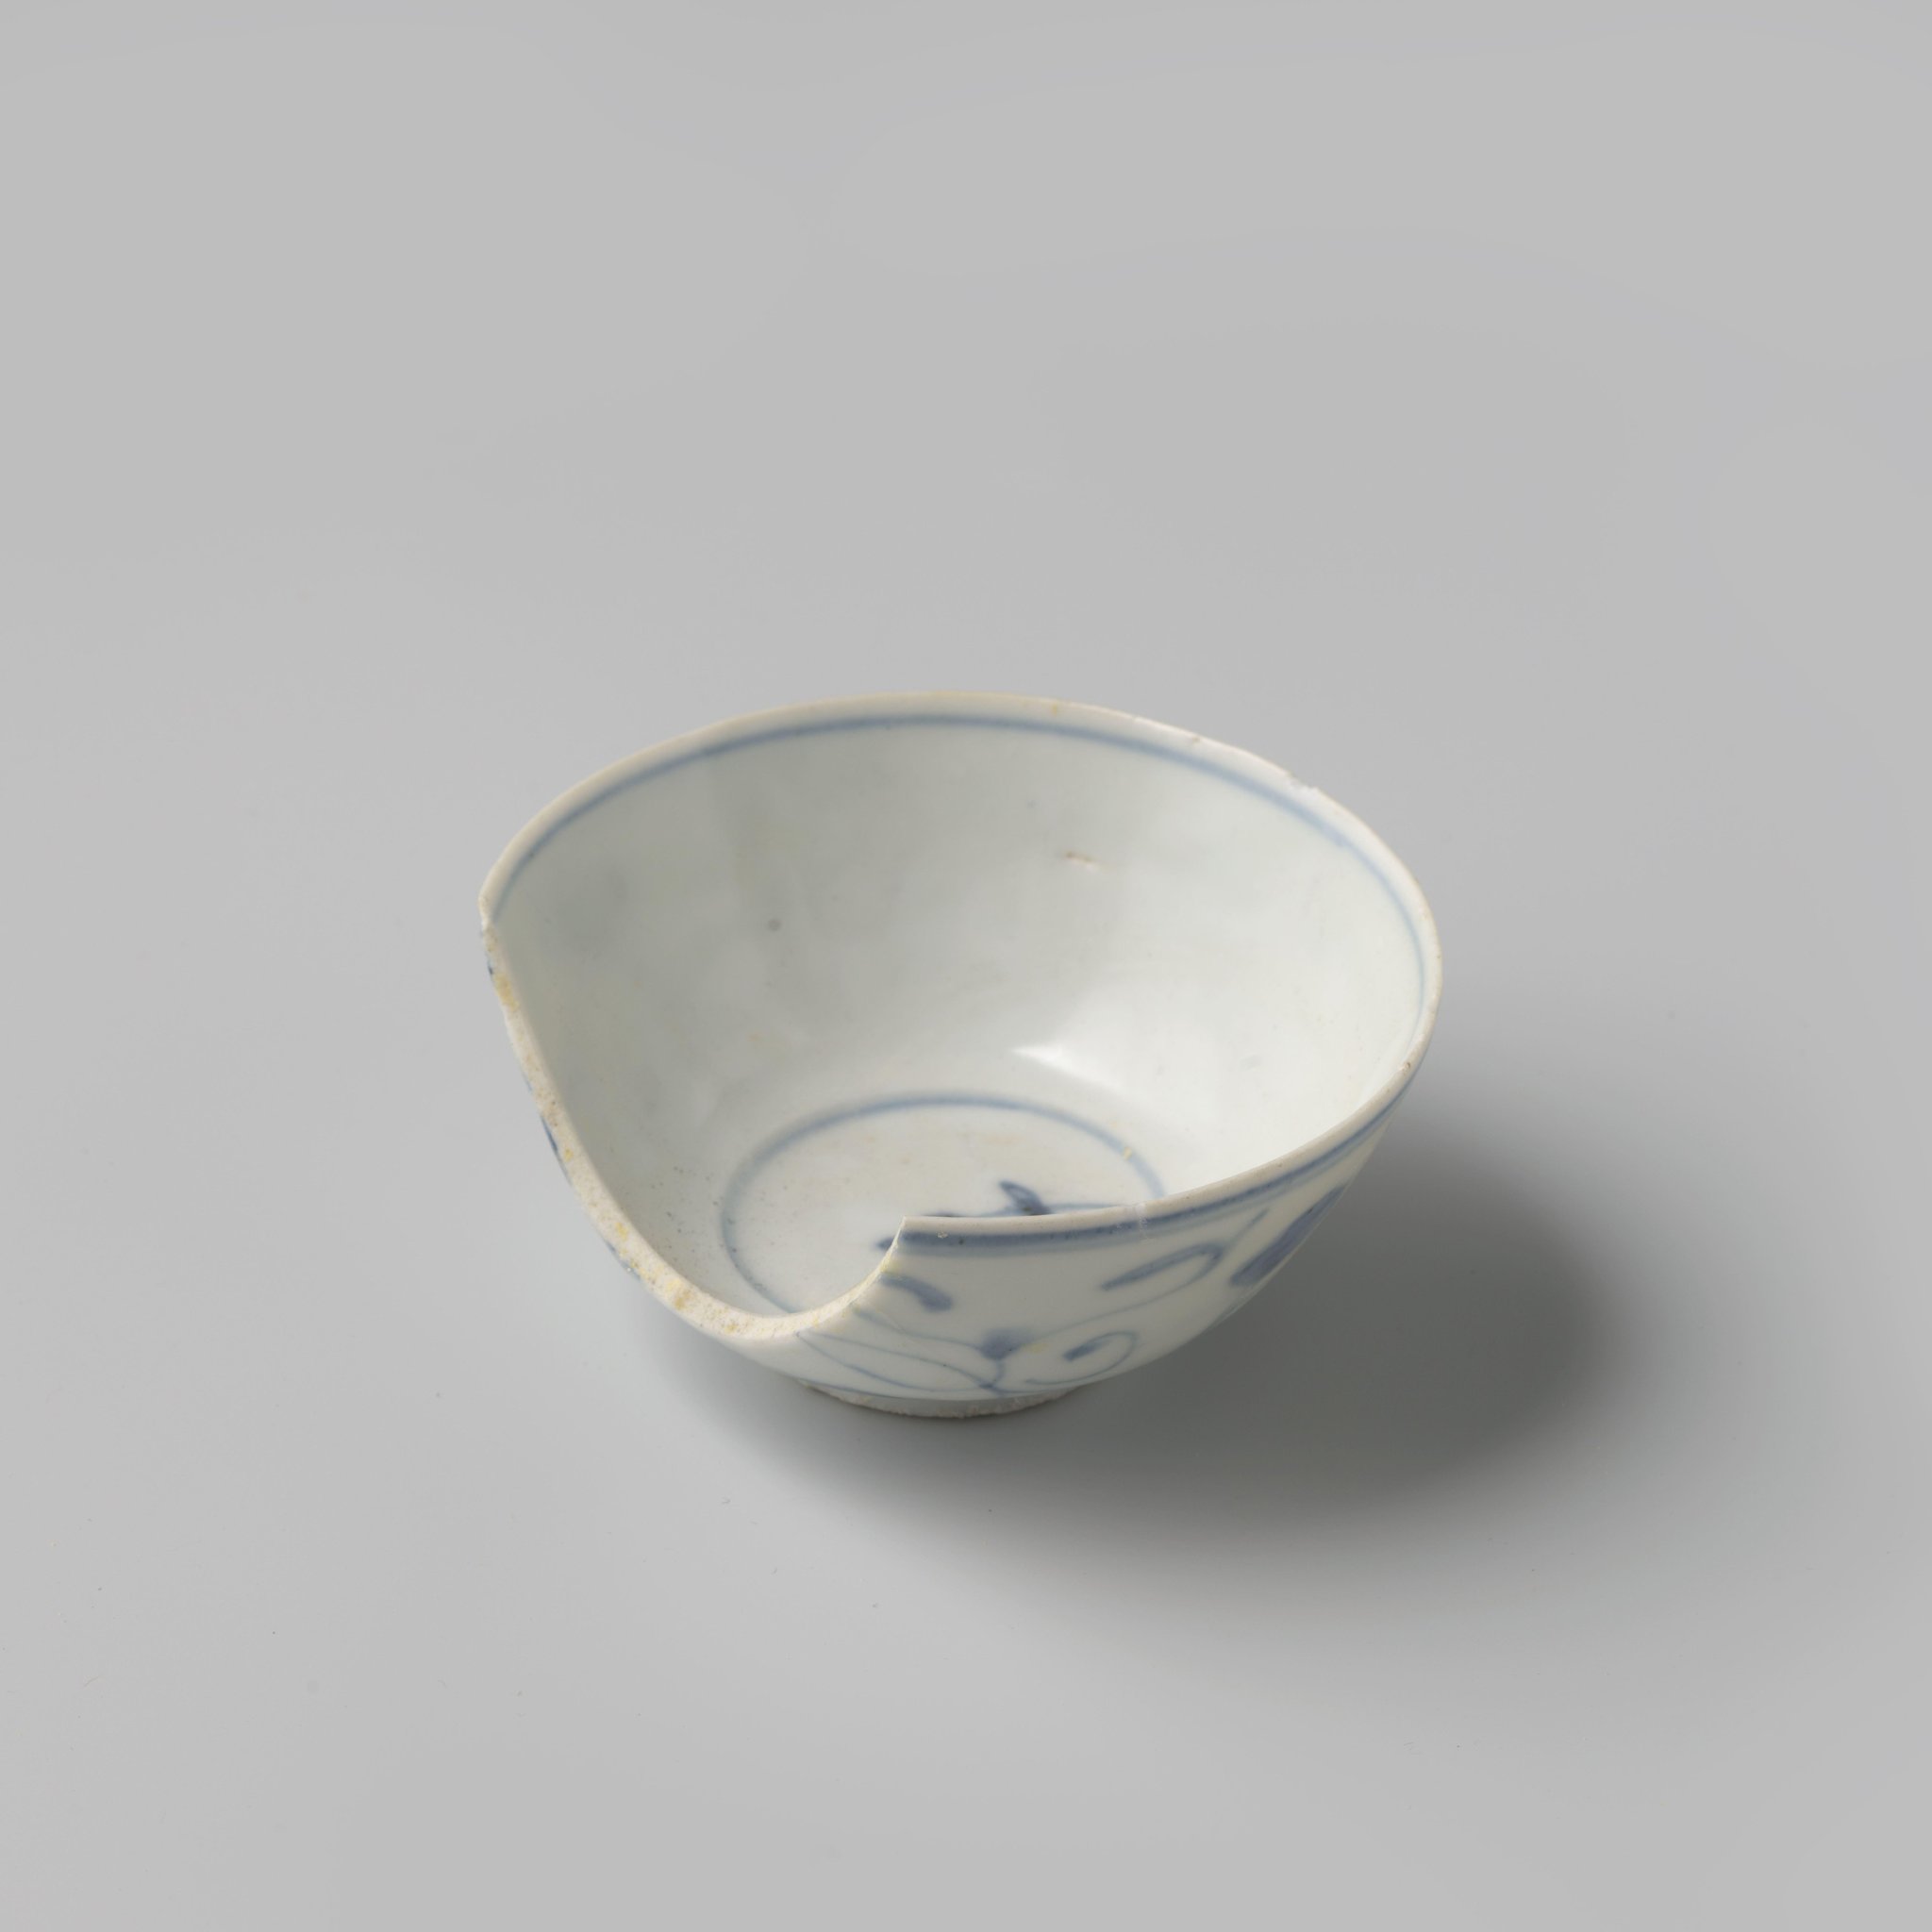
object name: bowl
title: Kom uit V.O.C.-schip de 'Witte Leeuw'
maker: Anonymous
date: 1613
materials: bone china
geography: jingdezhen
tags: verenigde oostindische compagnie, sint-helena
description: A dish without a flattened rim. An eight-sided thickly drawn medallion. A central decoration of a bird on a rock and a lotusplant in a marsh landscape. The medallions decorated with flowers, peaches and symbols.